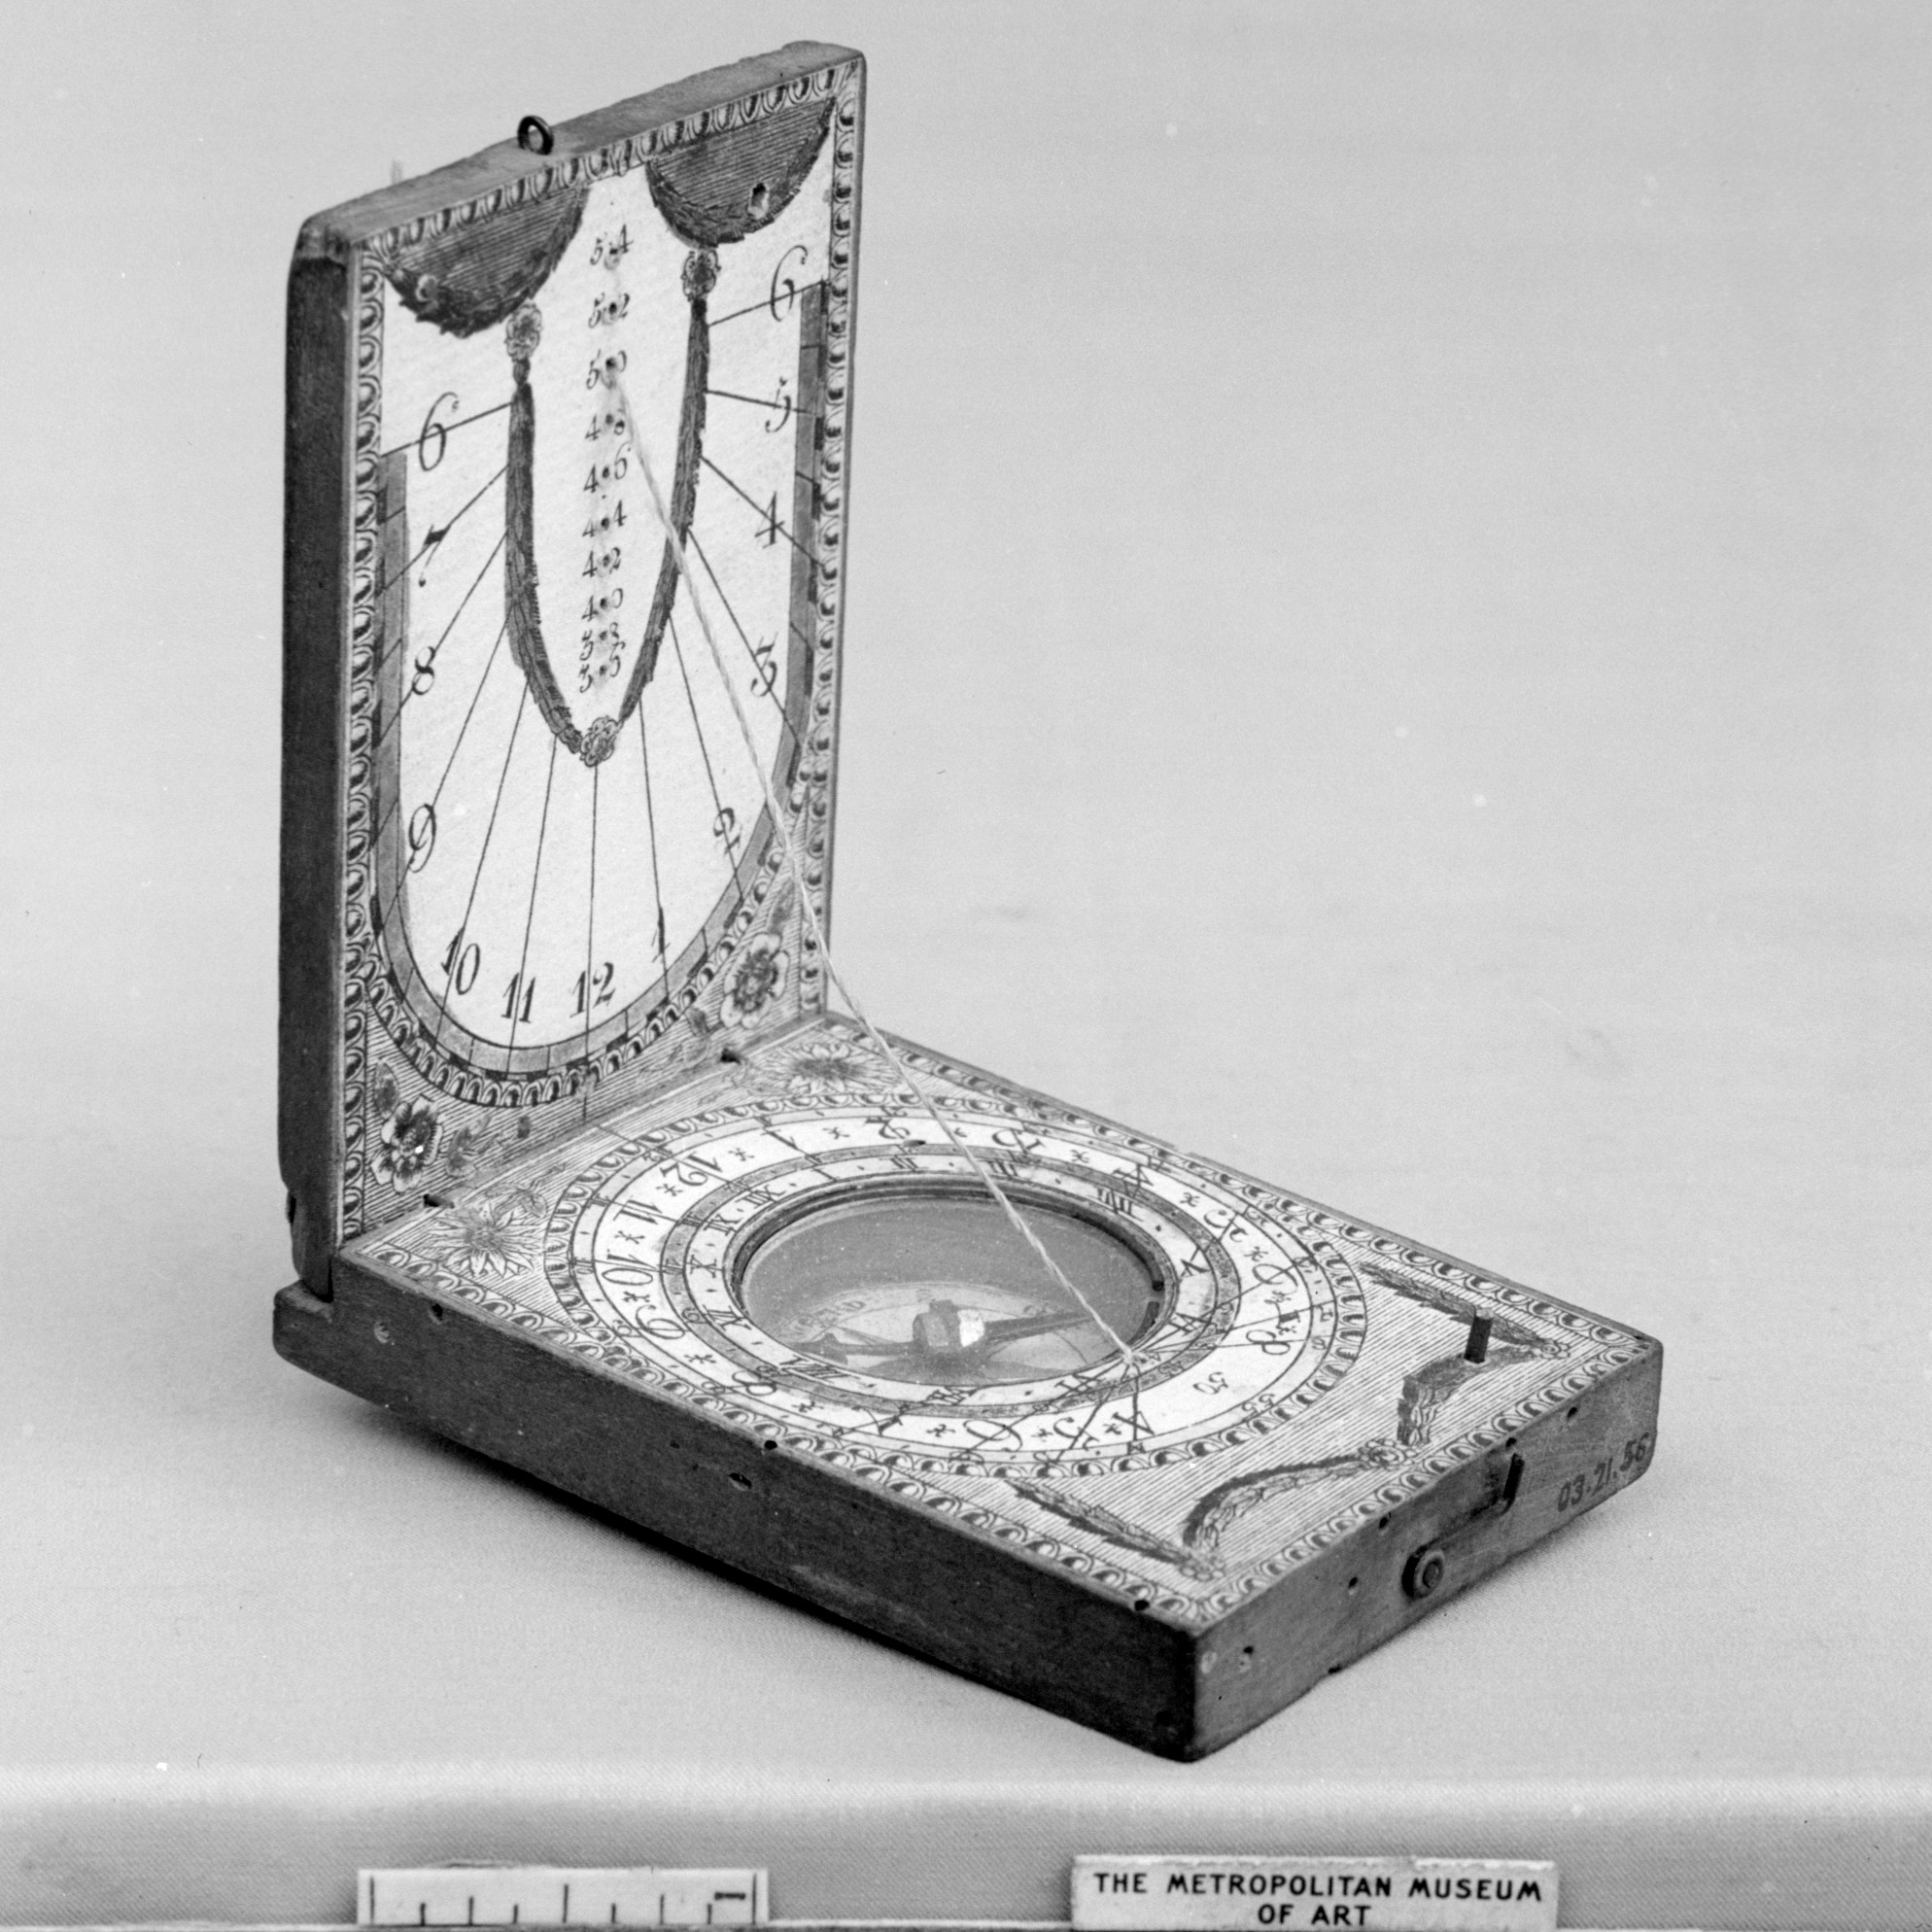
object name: portable compass dial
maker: e.c. stockert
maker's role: maker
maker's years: 1750-1850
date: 1701-1800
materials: wood